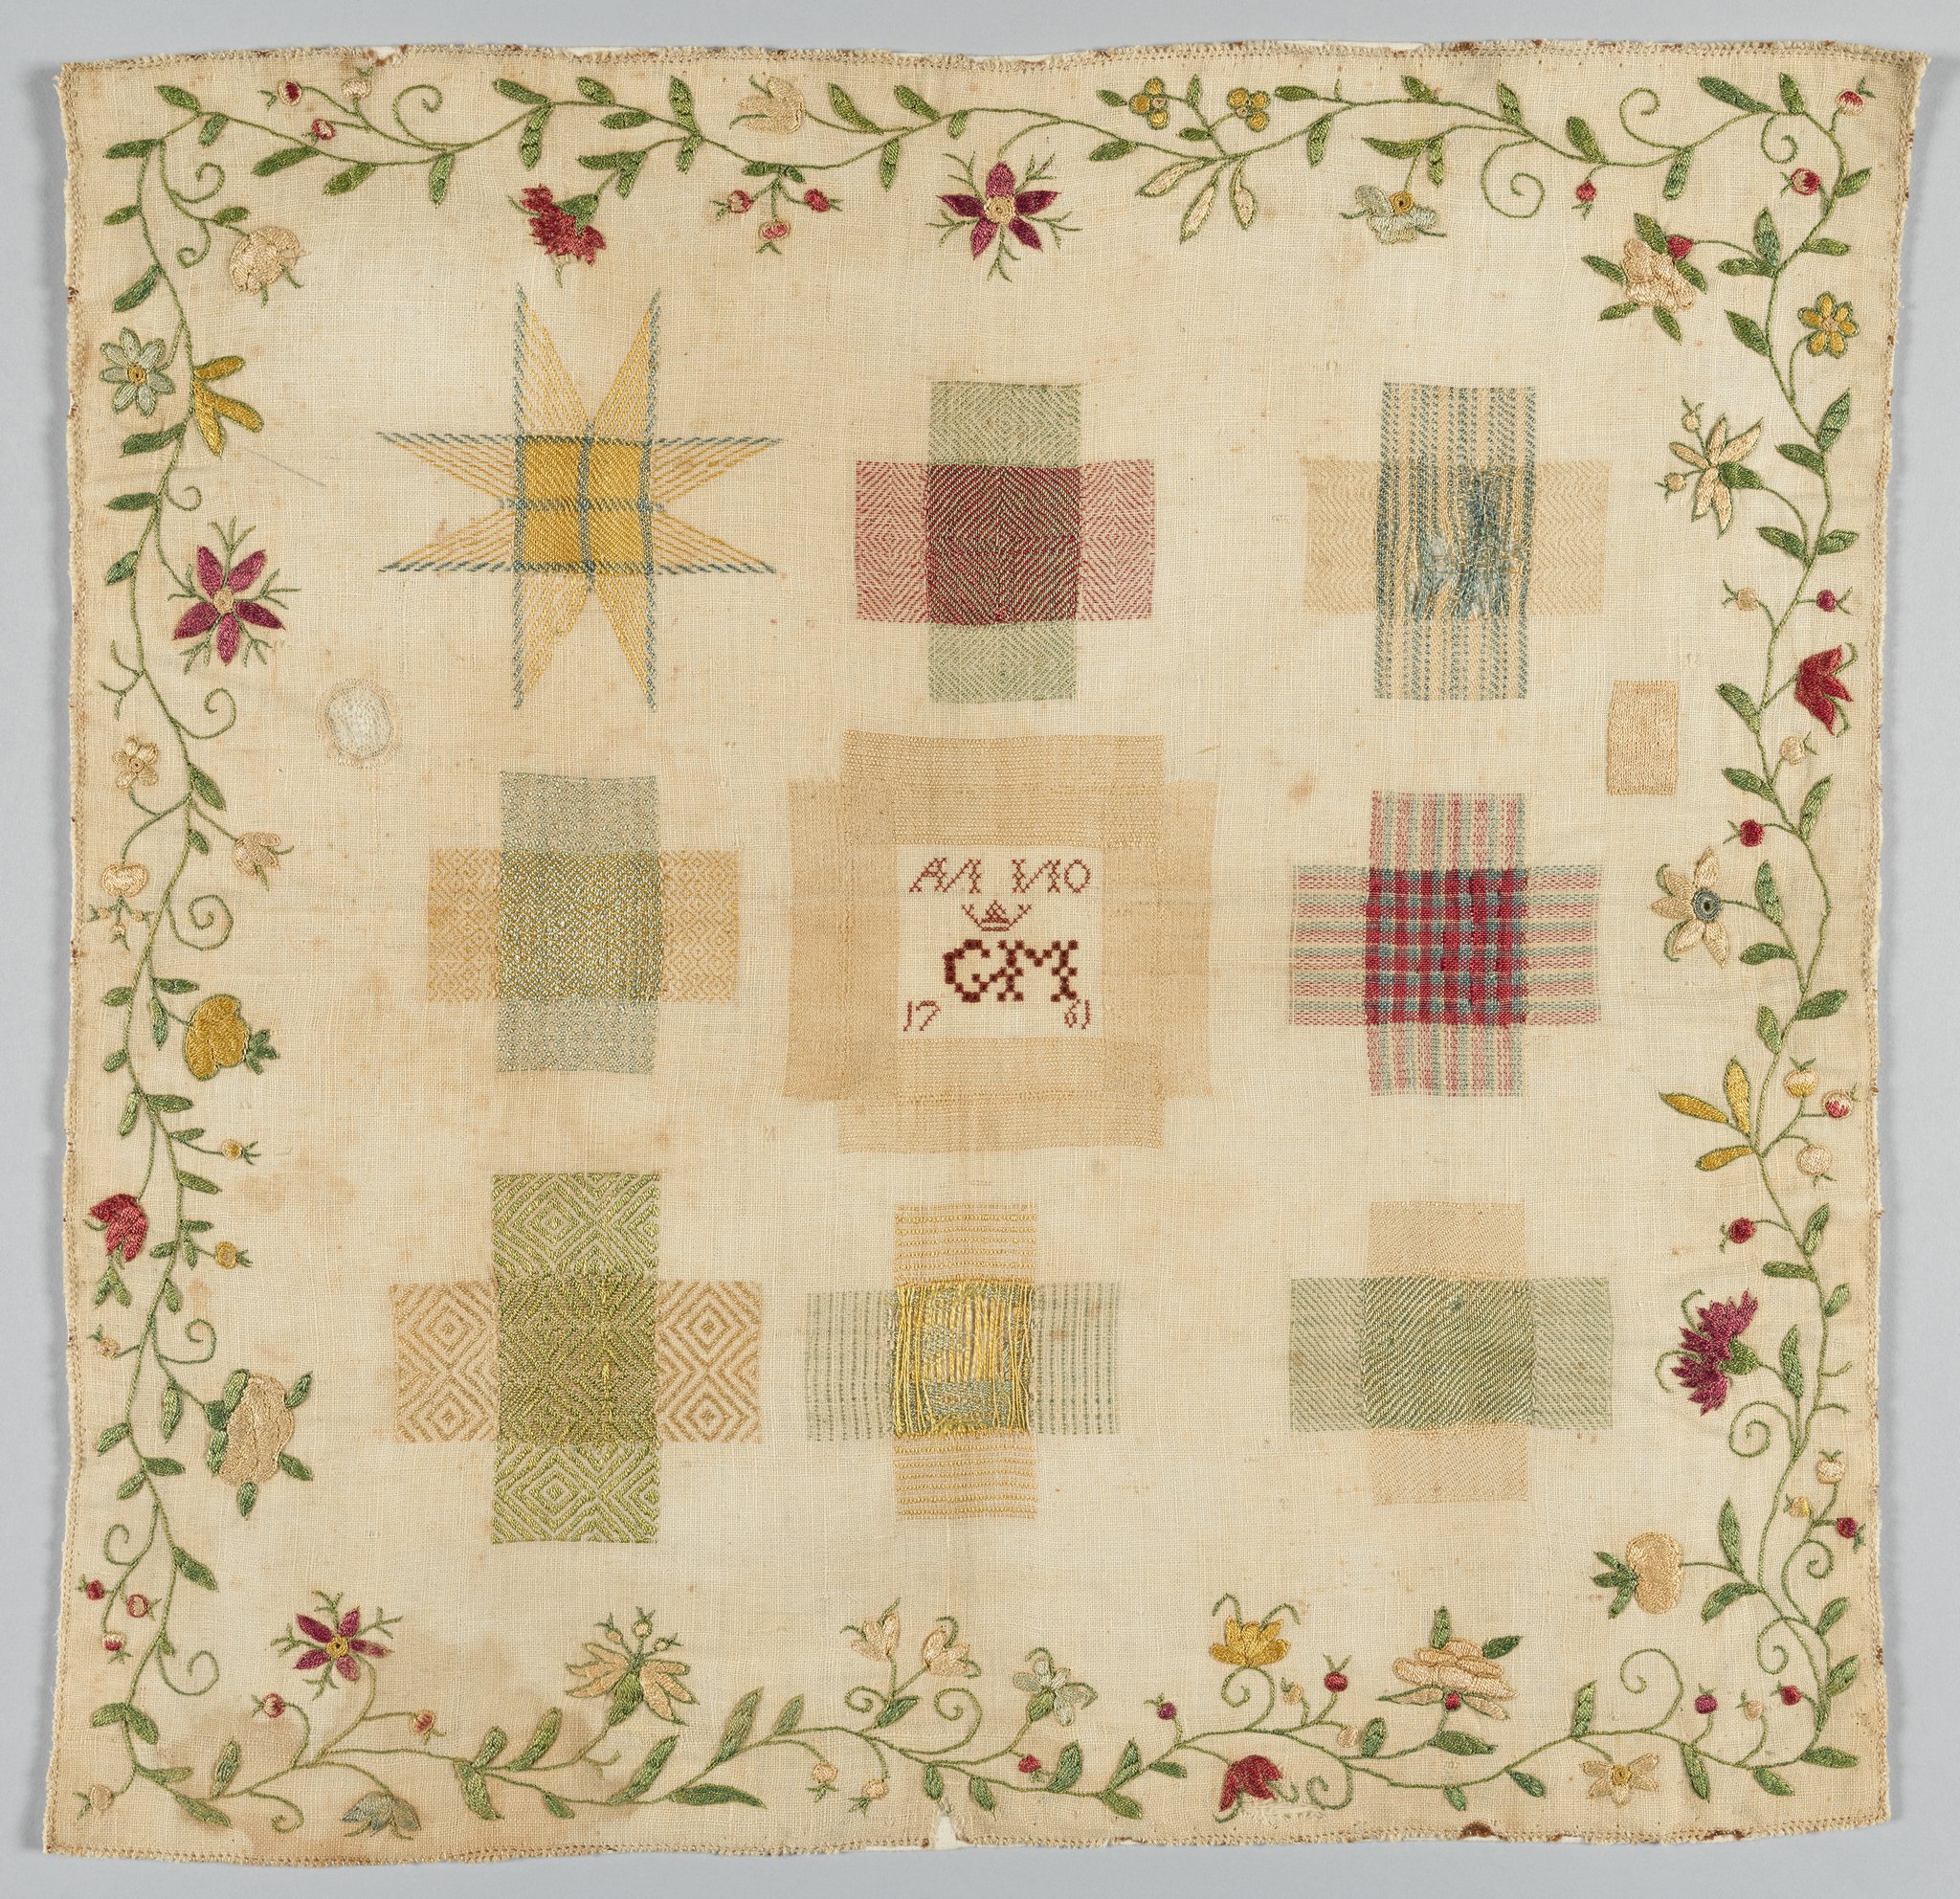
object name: sampler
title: Embroidered darning sampler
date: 1761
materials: linen, silk